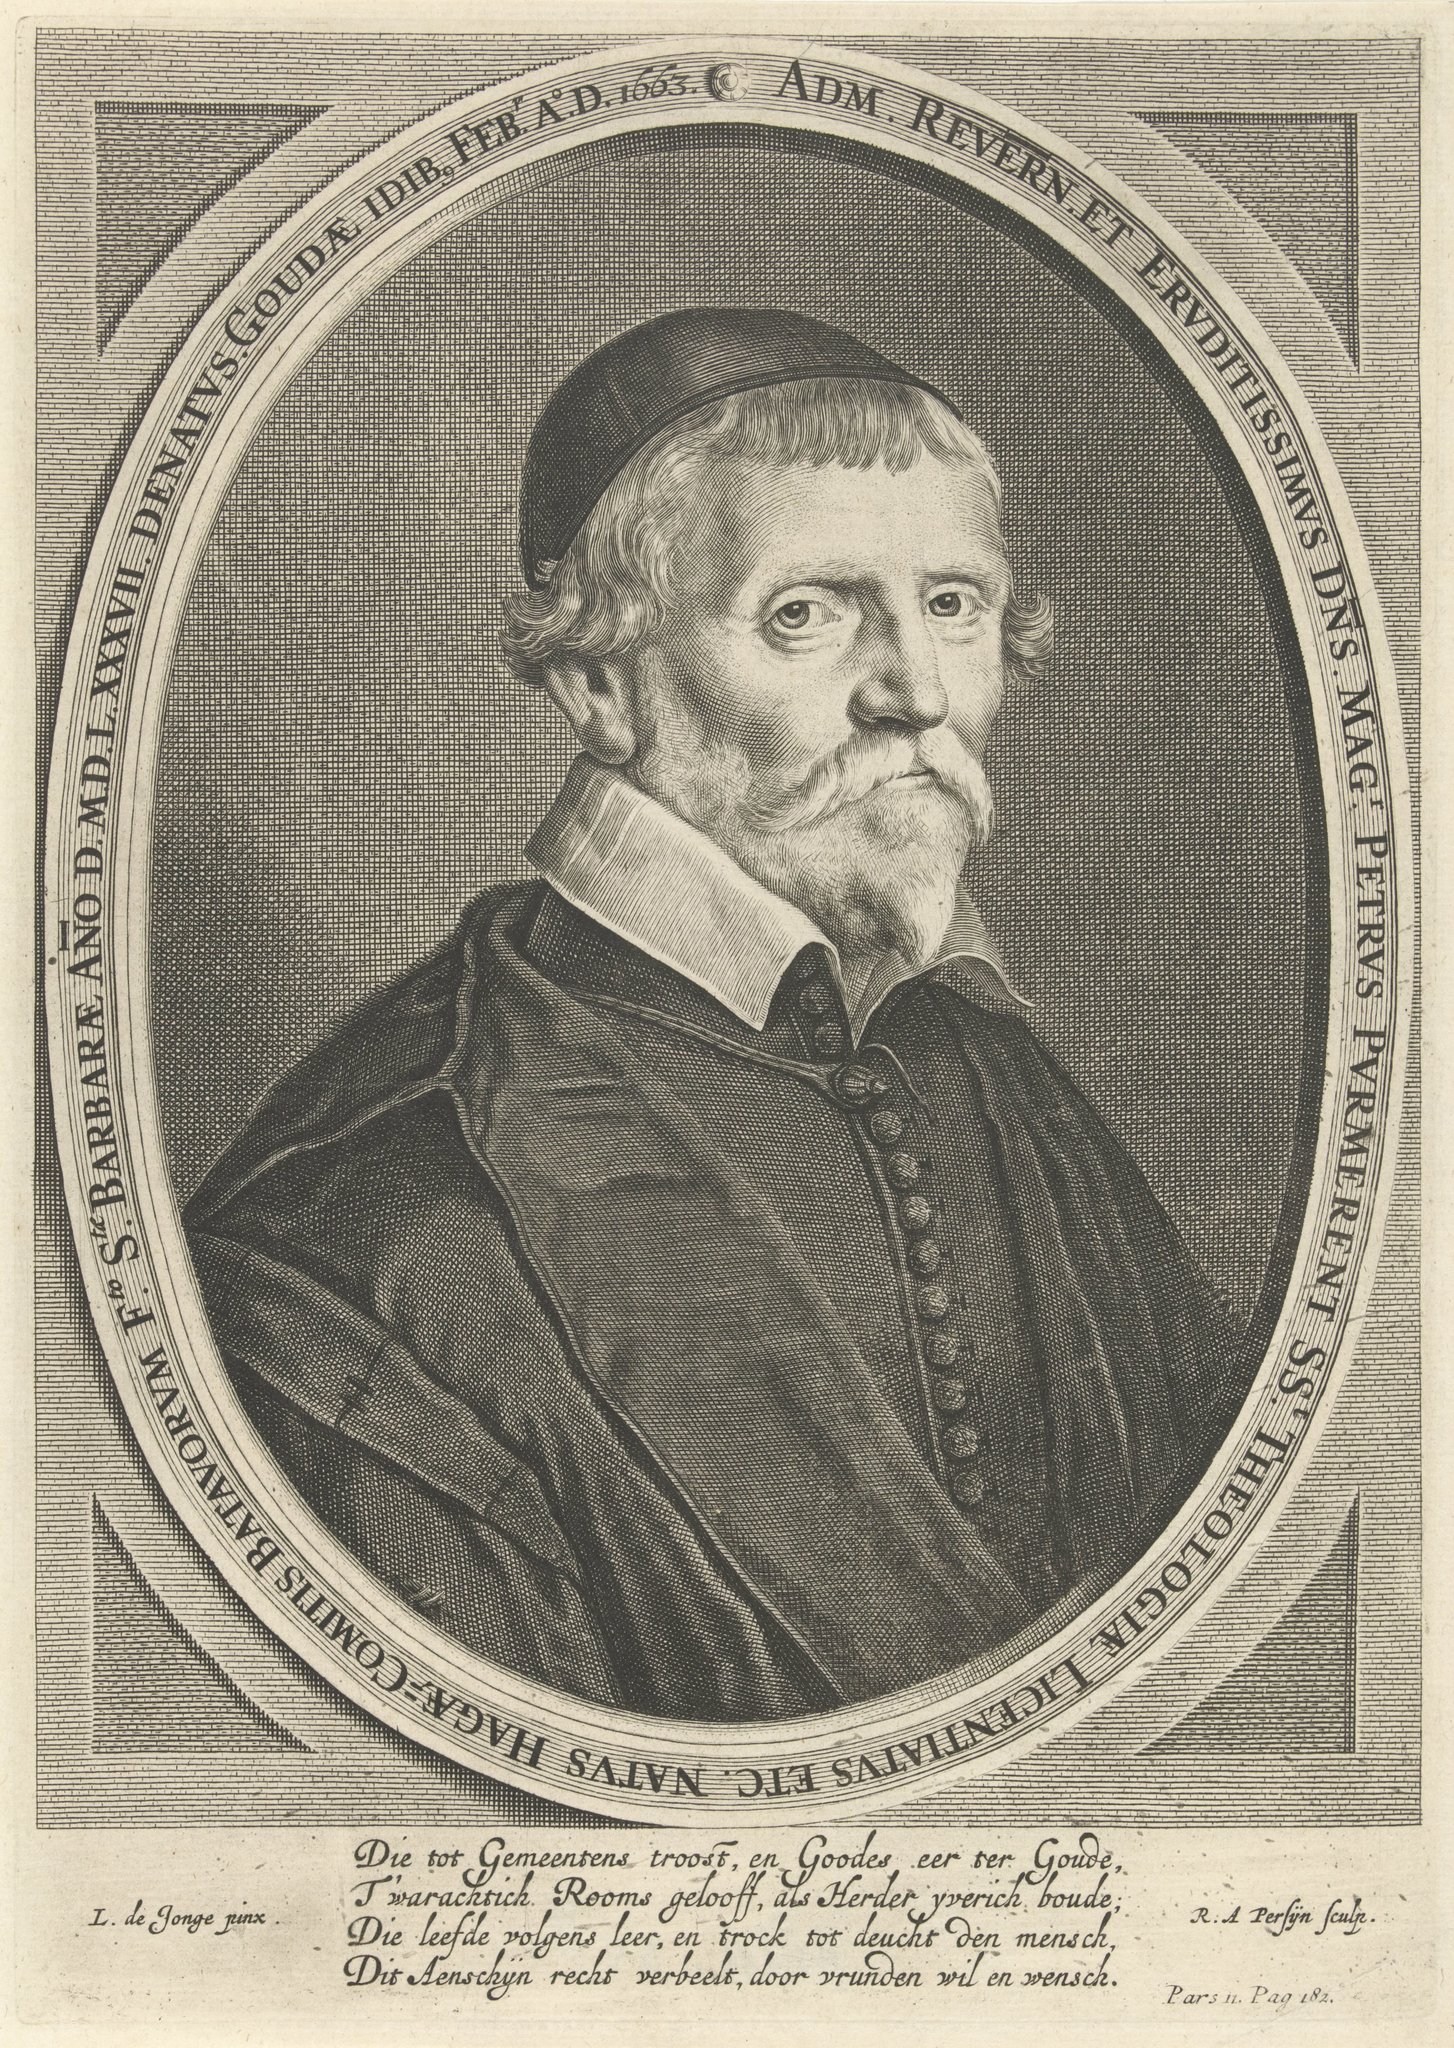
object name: book illustration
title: Portret van Petrus Purmerent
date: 1663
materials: paper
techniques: engraving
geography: gouda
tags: pastoor, petrus purmerent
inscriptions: collector's mark: Lugt 2228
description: Prent gebruikt in: Heussen, Hugo Franciscus van, Historia episcopatuum Foederati Belgii; utpote metropolitani Ultrajectini, nec non suffraganeorum Harlemensis, Daventriensis, Leovardensis, Groningensis, et Middelburgensis. Leiden: Christiaan Vermey, 1719.